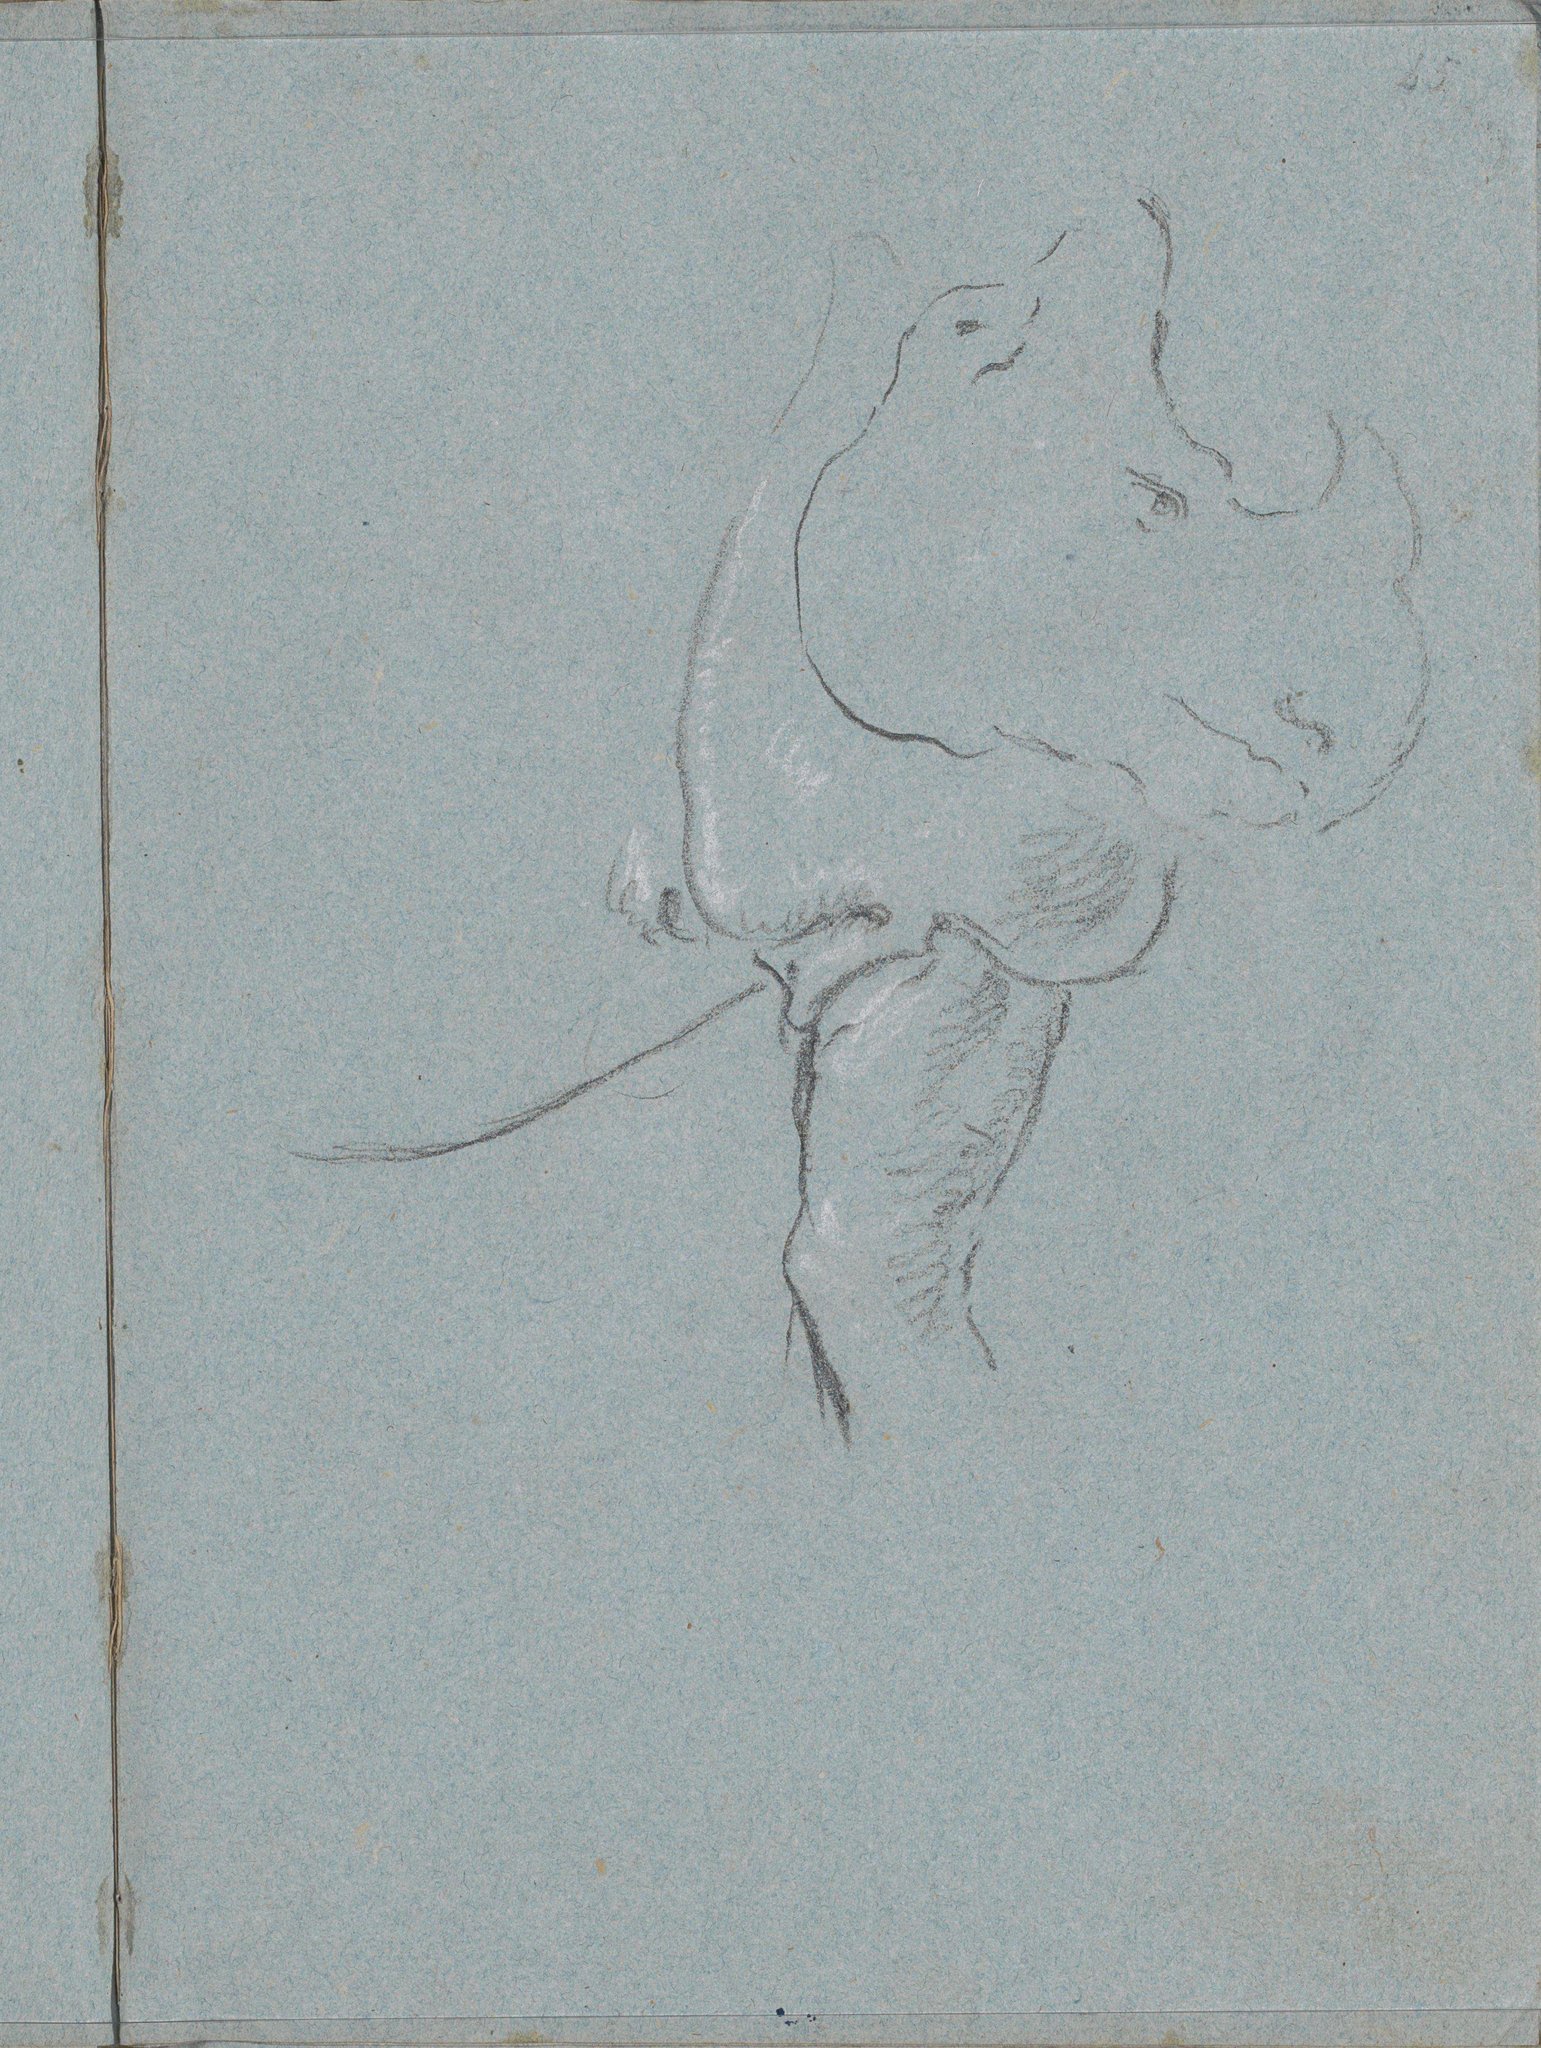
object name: sketchbook leaf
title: Kop en voorste deel van neushoorn Clara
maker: lorenzo baldissera tiepolo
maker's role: draughtsman, print maker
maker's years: 1736-1776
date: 1751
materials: chalk, paper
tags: hoofed animals: rhinoceros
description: Studie naar de neushoorn Clara, die vanaf 1746 een rondreis door Europa maakte (zie documentatie).